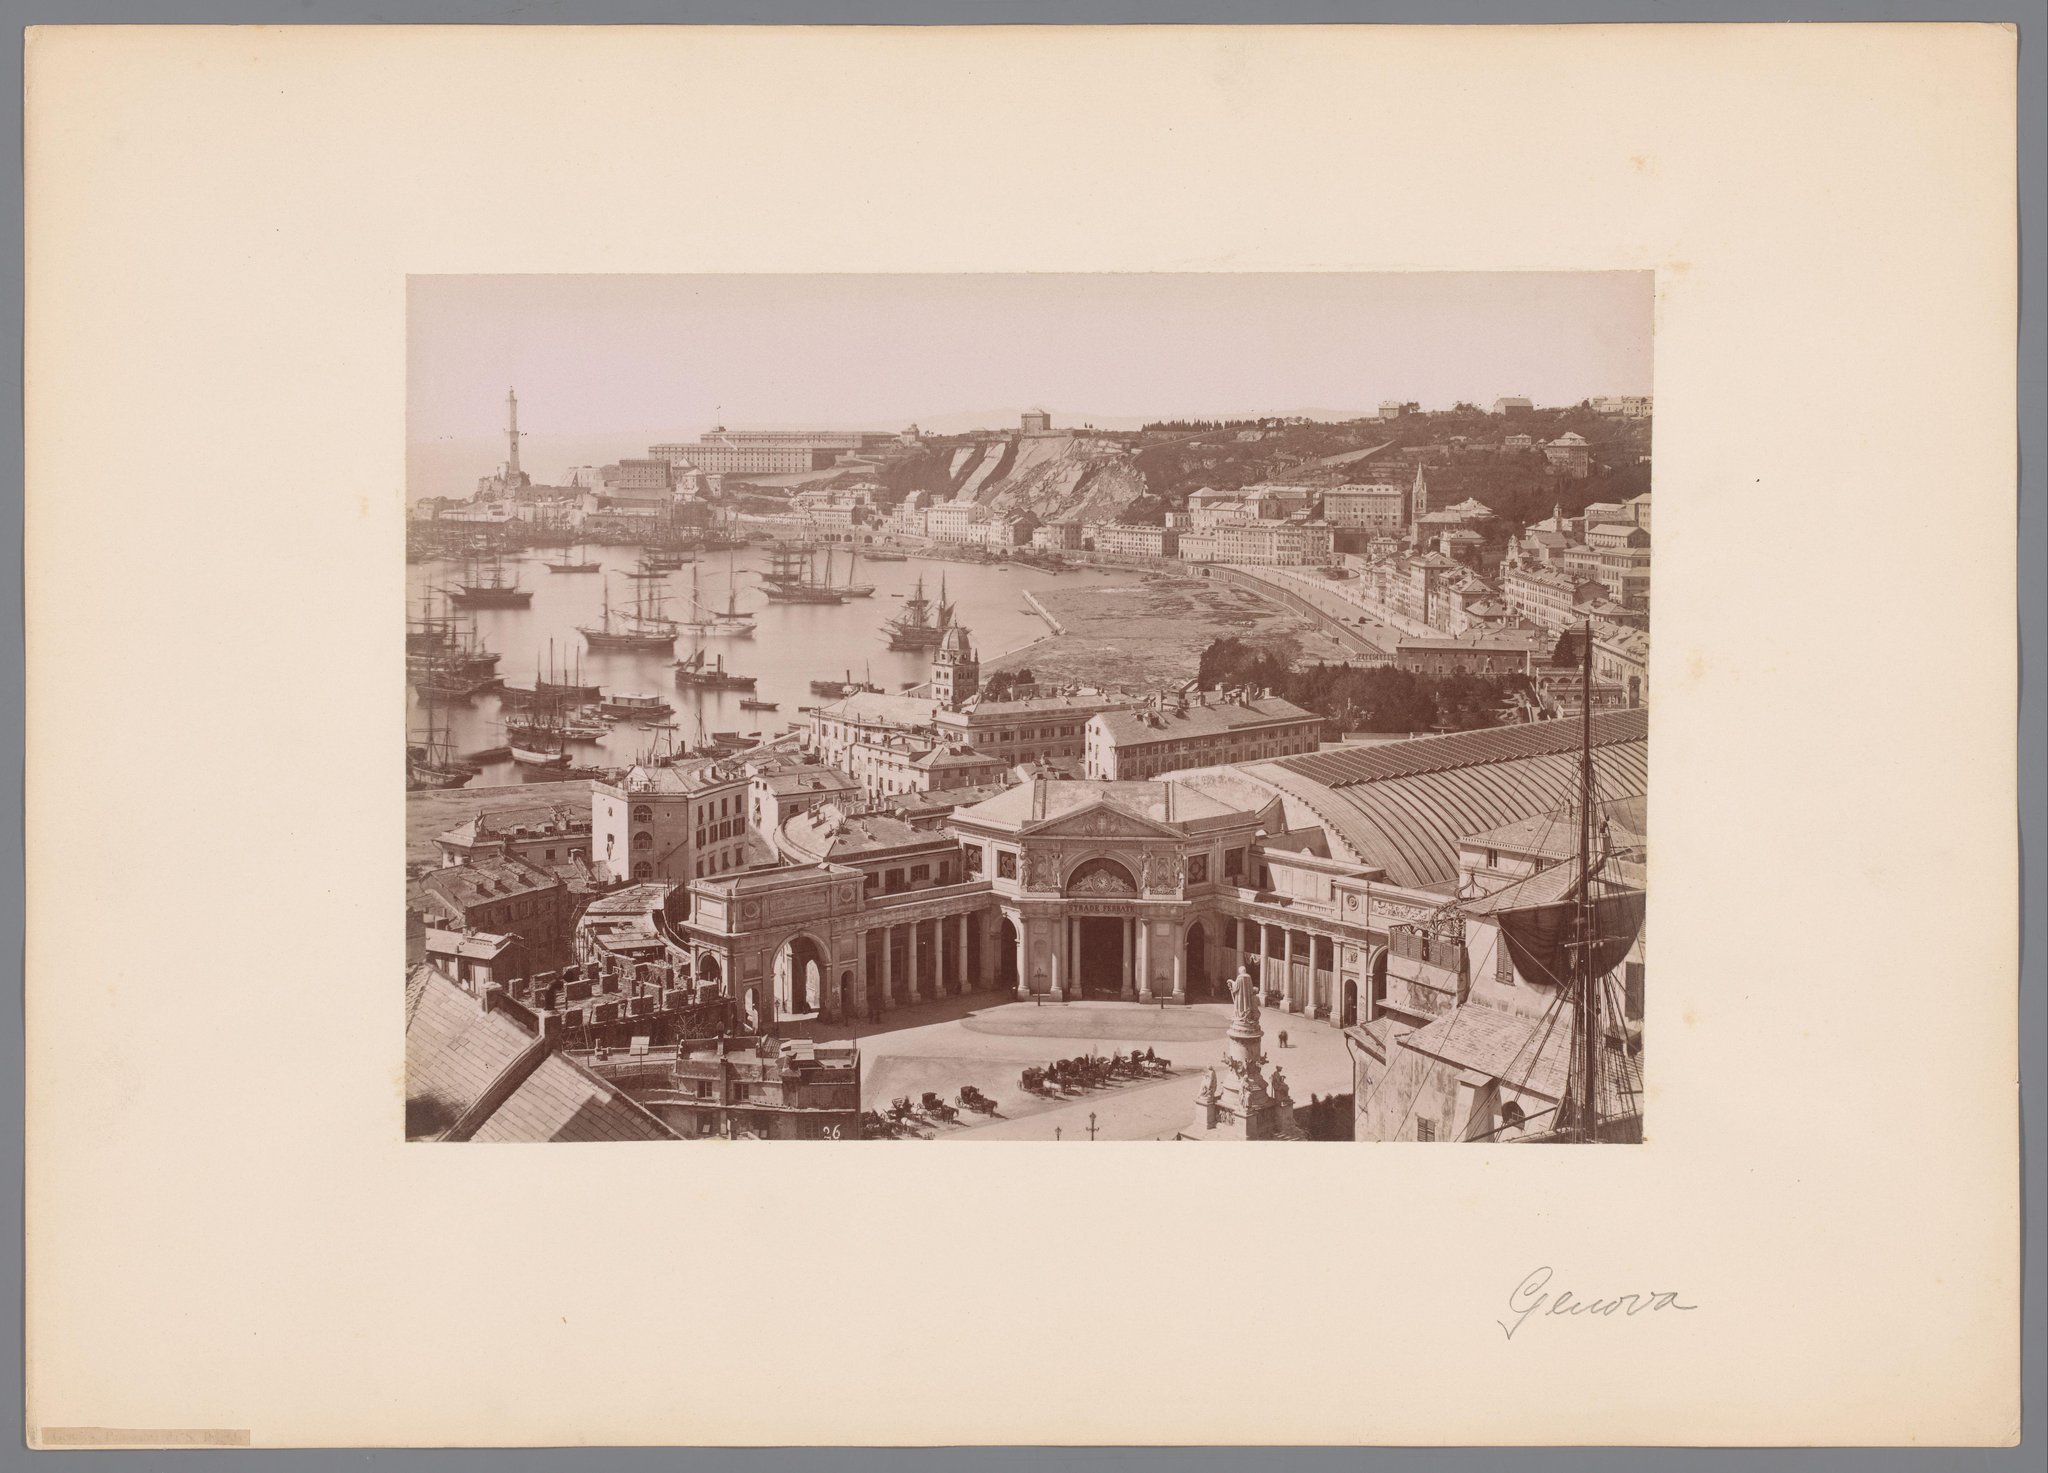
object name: photograph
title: Panorama di S. Ferata [?]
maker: alfredo noack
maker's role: fotograaf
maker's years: 1833-1895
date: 1858-1893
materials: cardboard, paper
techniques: albumen print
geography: genoa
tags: harbour, ships (in general)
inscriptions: inscription: ‘Noack (t)’, inscription: ‘Genova’, number: ‘28’, number: ‘26’